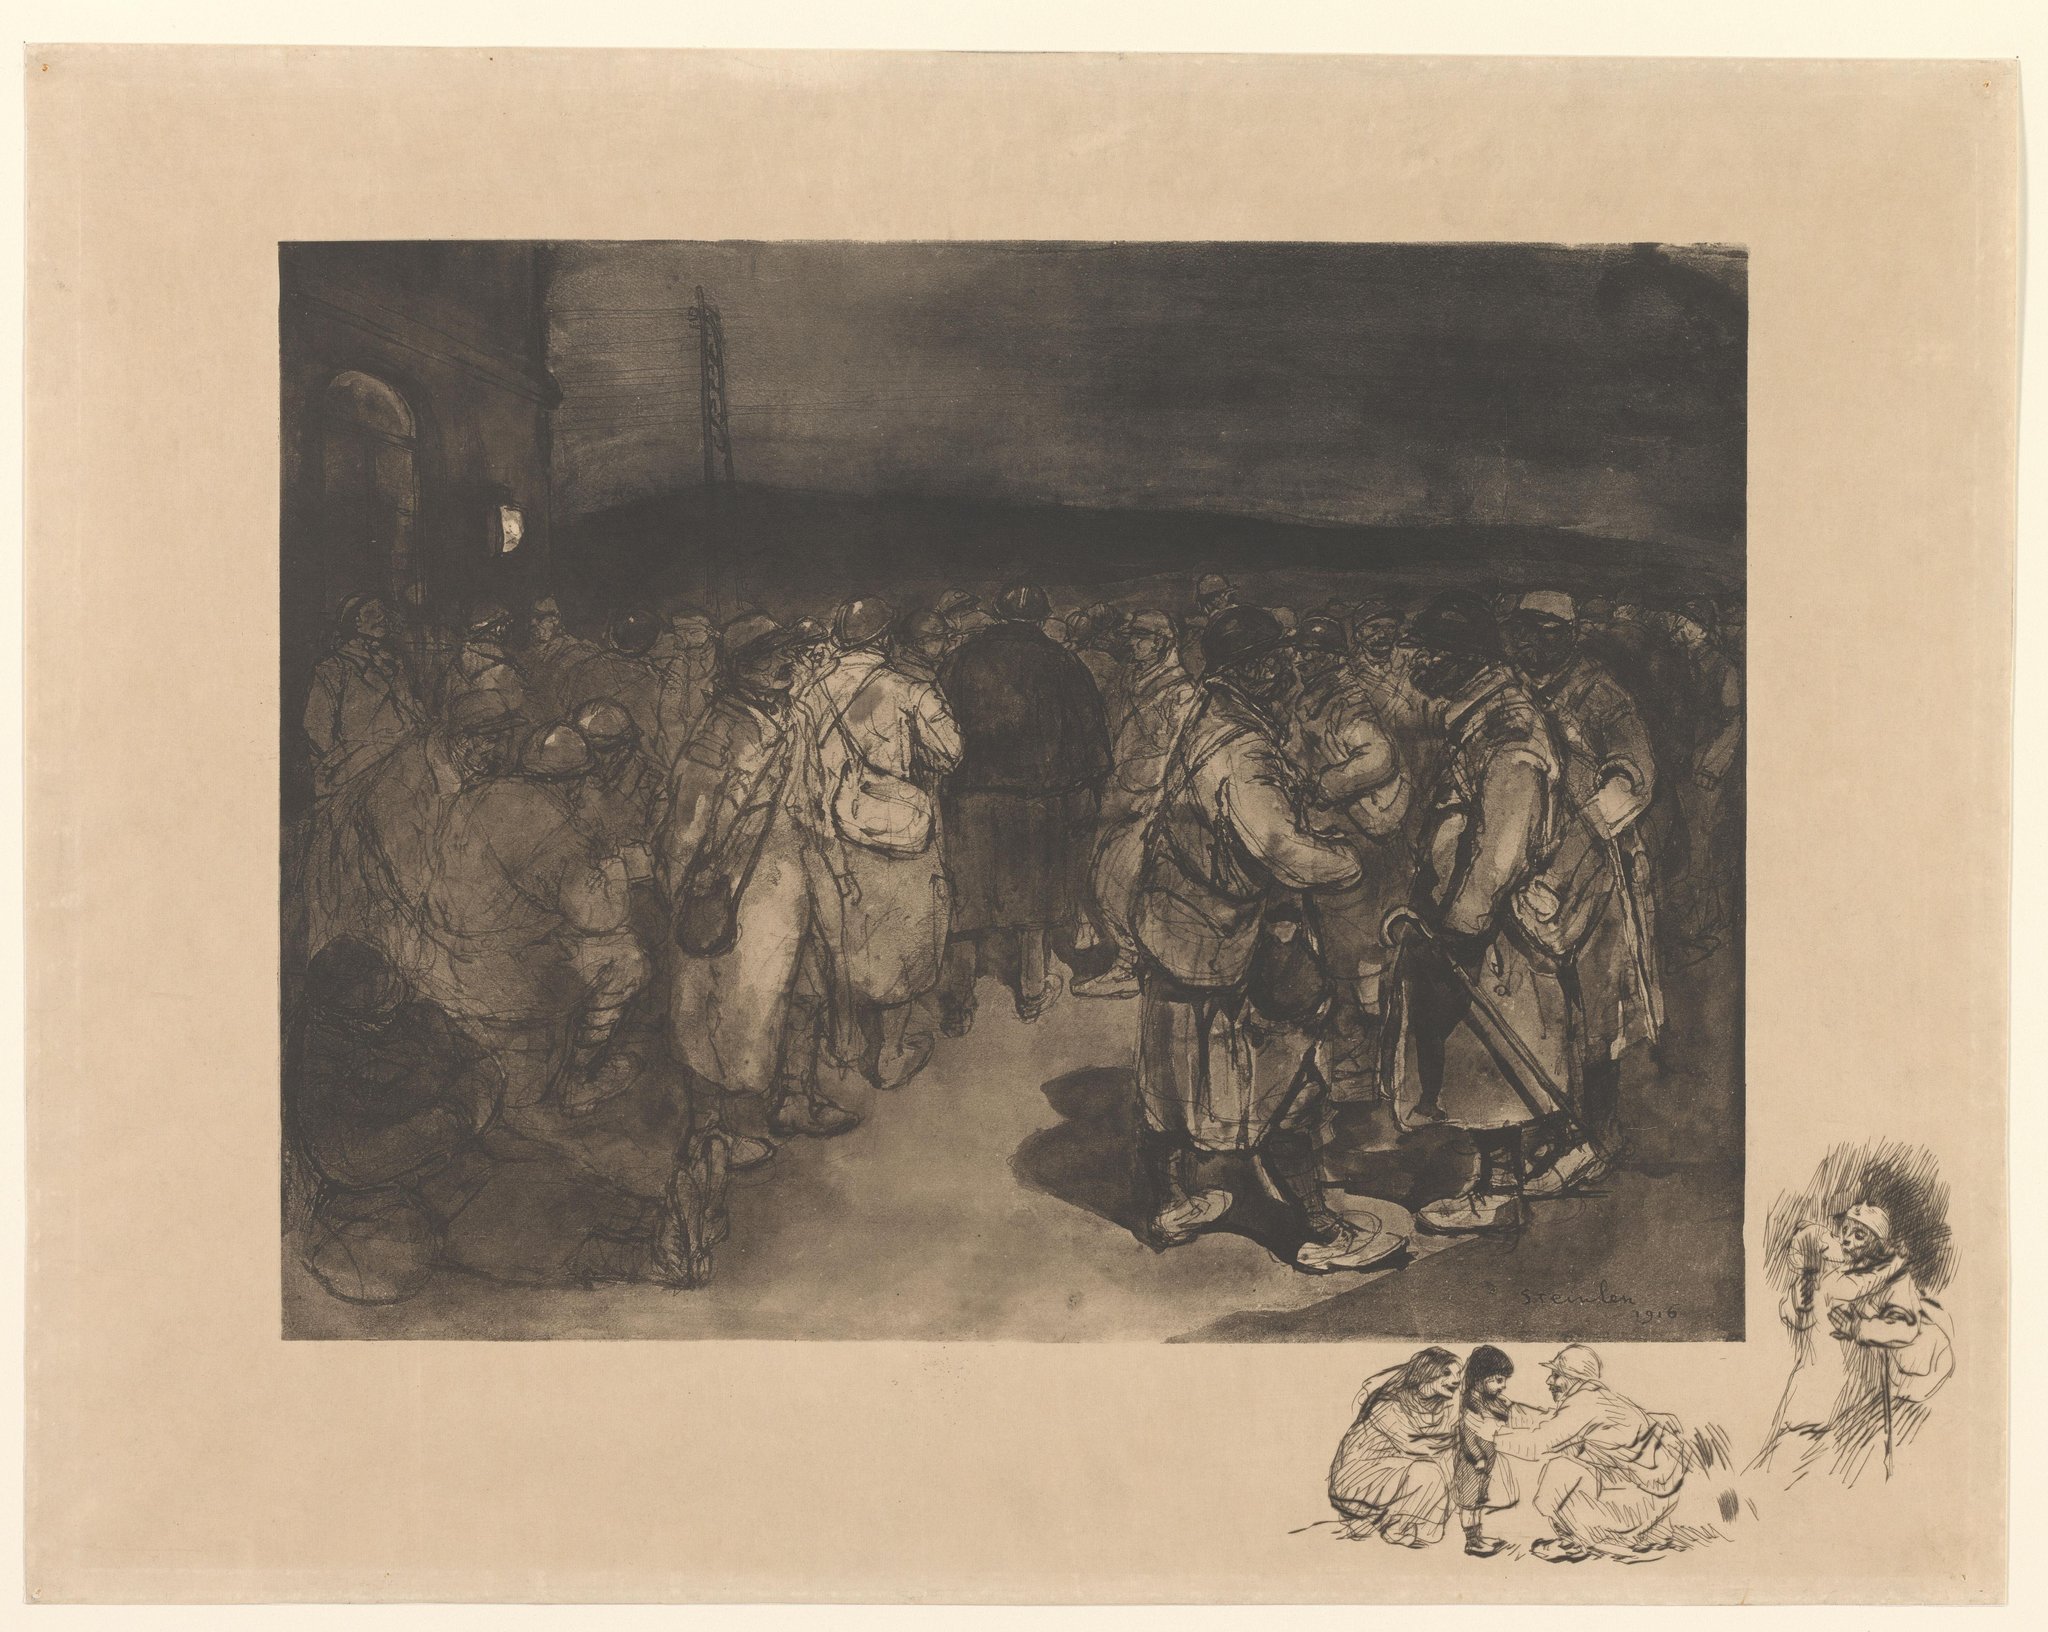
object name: print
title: Clemenceau aan het front, 1916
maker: théophile alexandre steinlen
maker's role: draughtsman, painter, print maker, sculptor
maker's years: 1859-1923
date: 1916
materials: paper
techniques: aquatint, etching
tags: return of the soldiers to civilian life, returning home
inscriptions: collector's mark: Lugt 2228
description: Onderaan in de marge twee scènes van soldaten die thuiskomen: een man knielt bij een vrouw met een kind, en een man omhelst zijn geliefde.